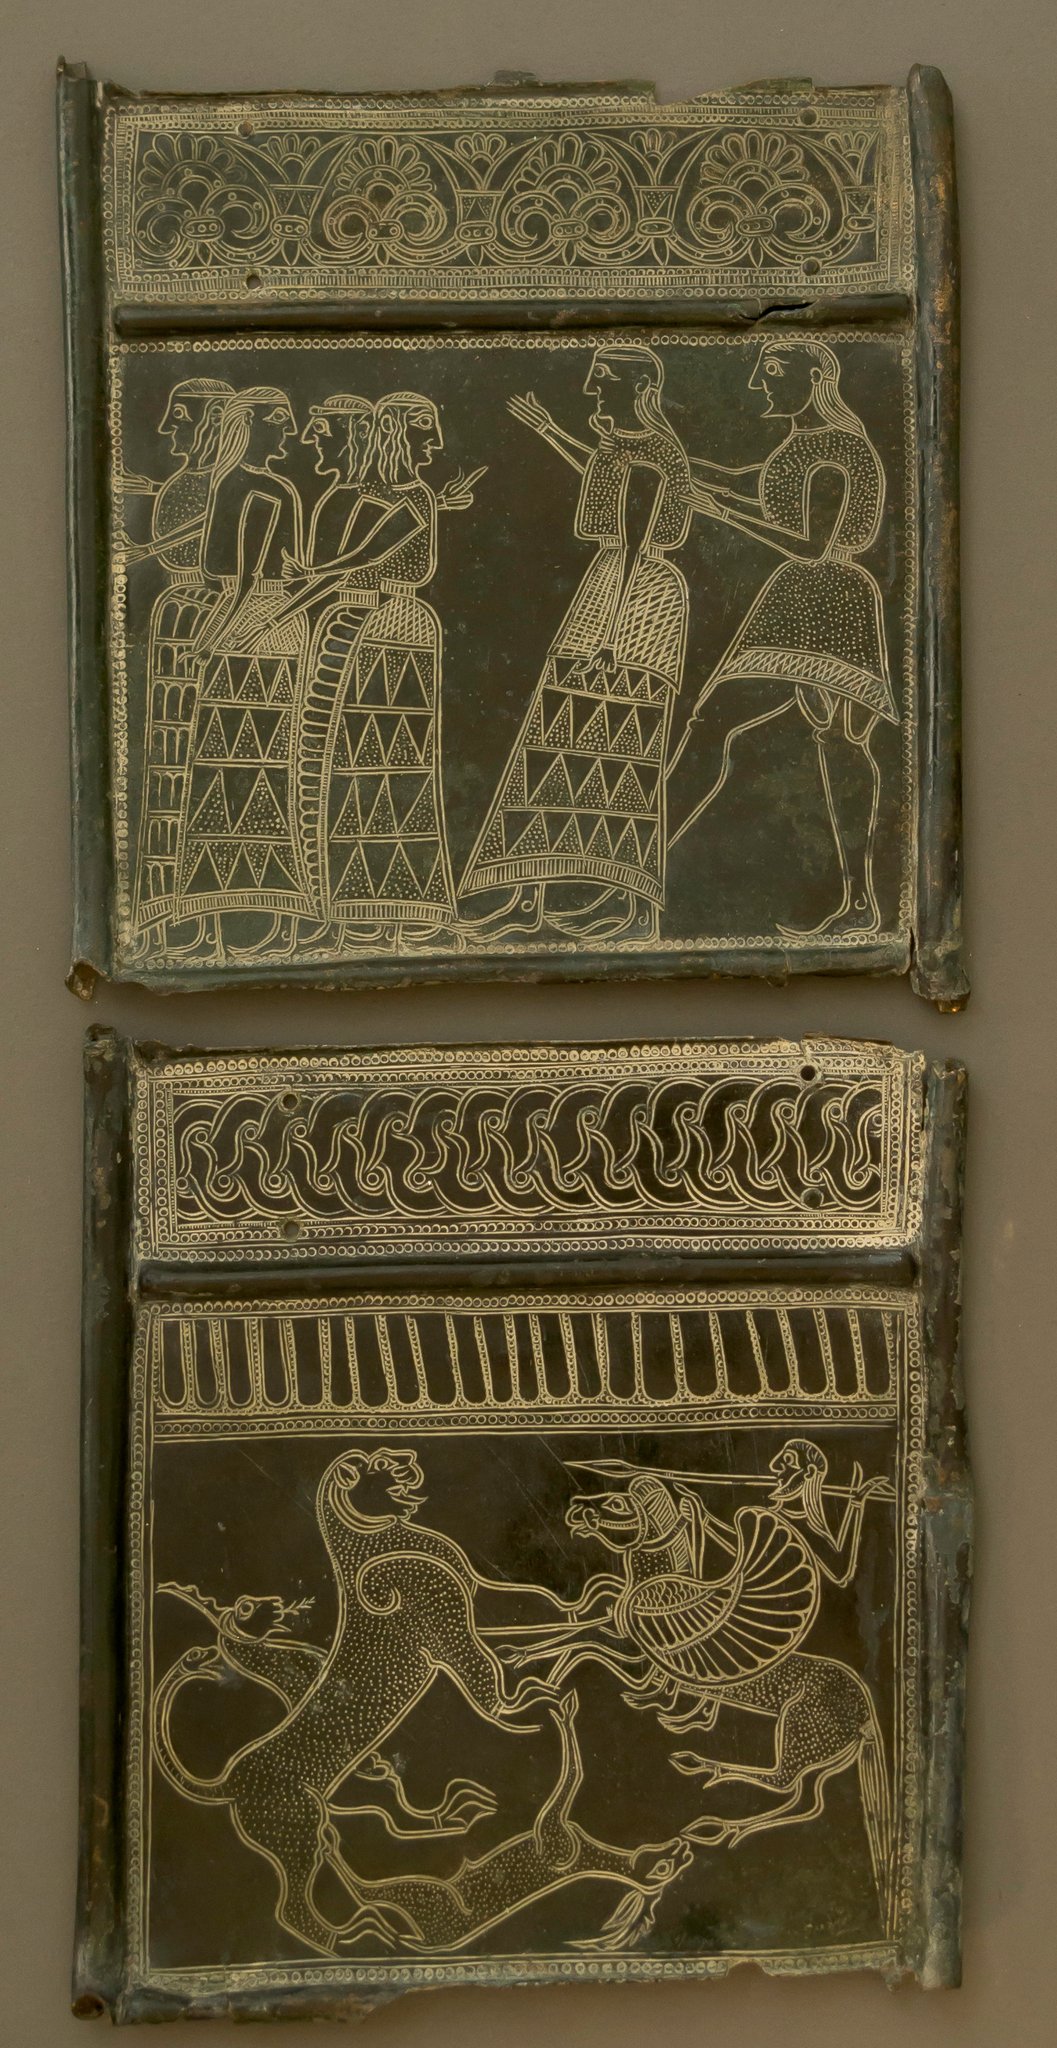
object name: tripod leg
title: Tripod leg ?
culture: greek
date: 675-650 BCE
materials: bronze